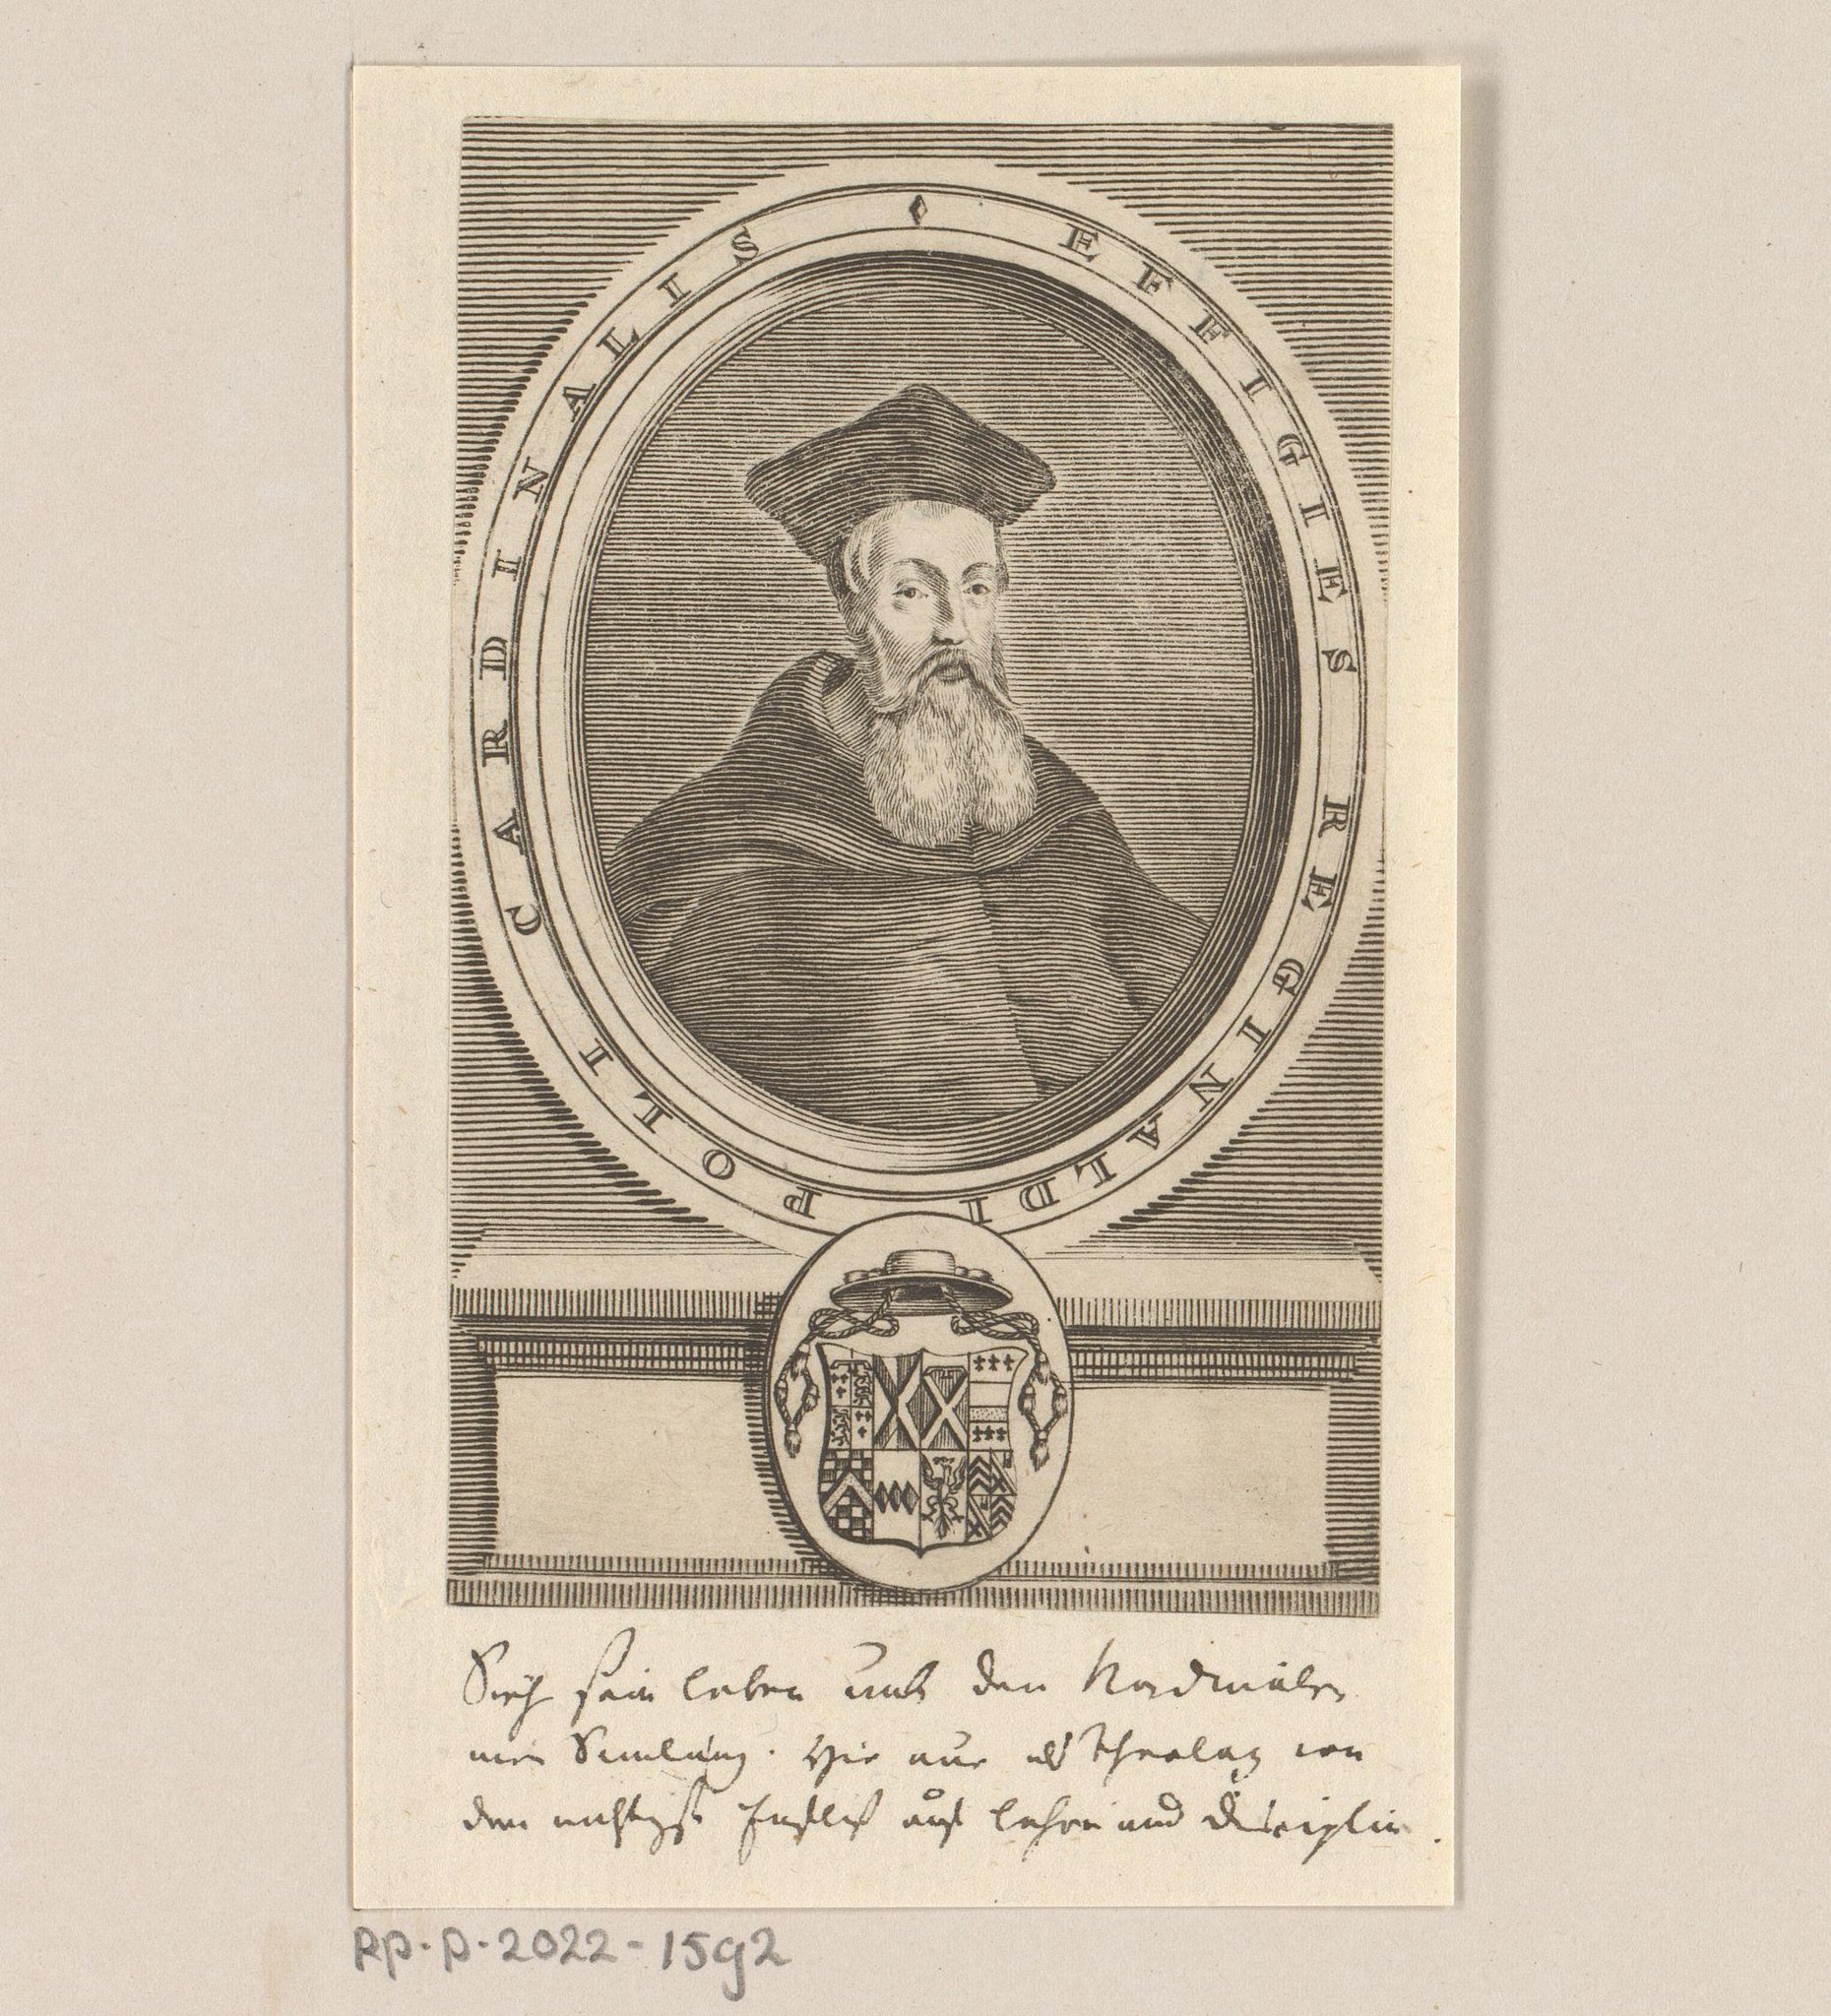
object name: print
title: Portret van Reginald Pole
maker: Anonymous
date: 1550-1699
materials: paper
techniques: engraving, snipping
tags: cardinal, historical persons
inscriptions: inscription: ‘Ons [...]’